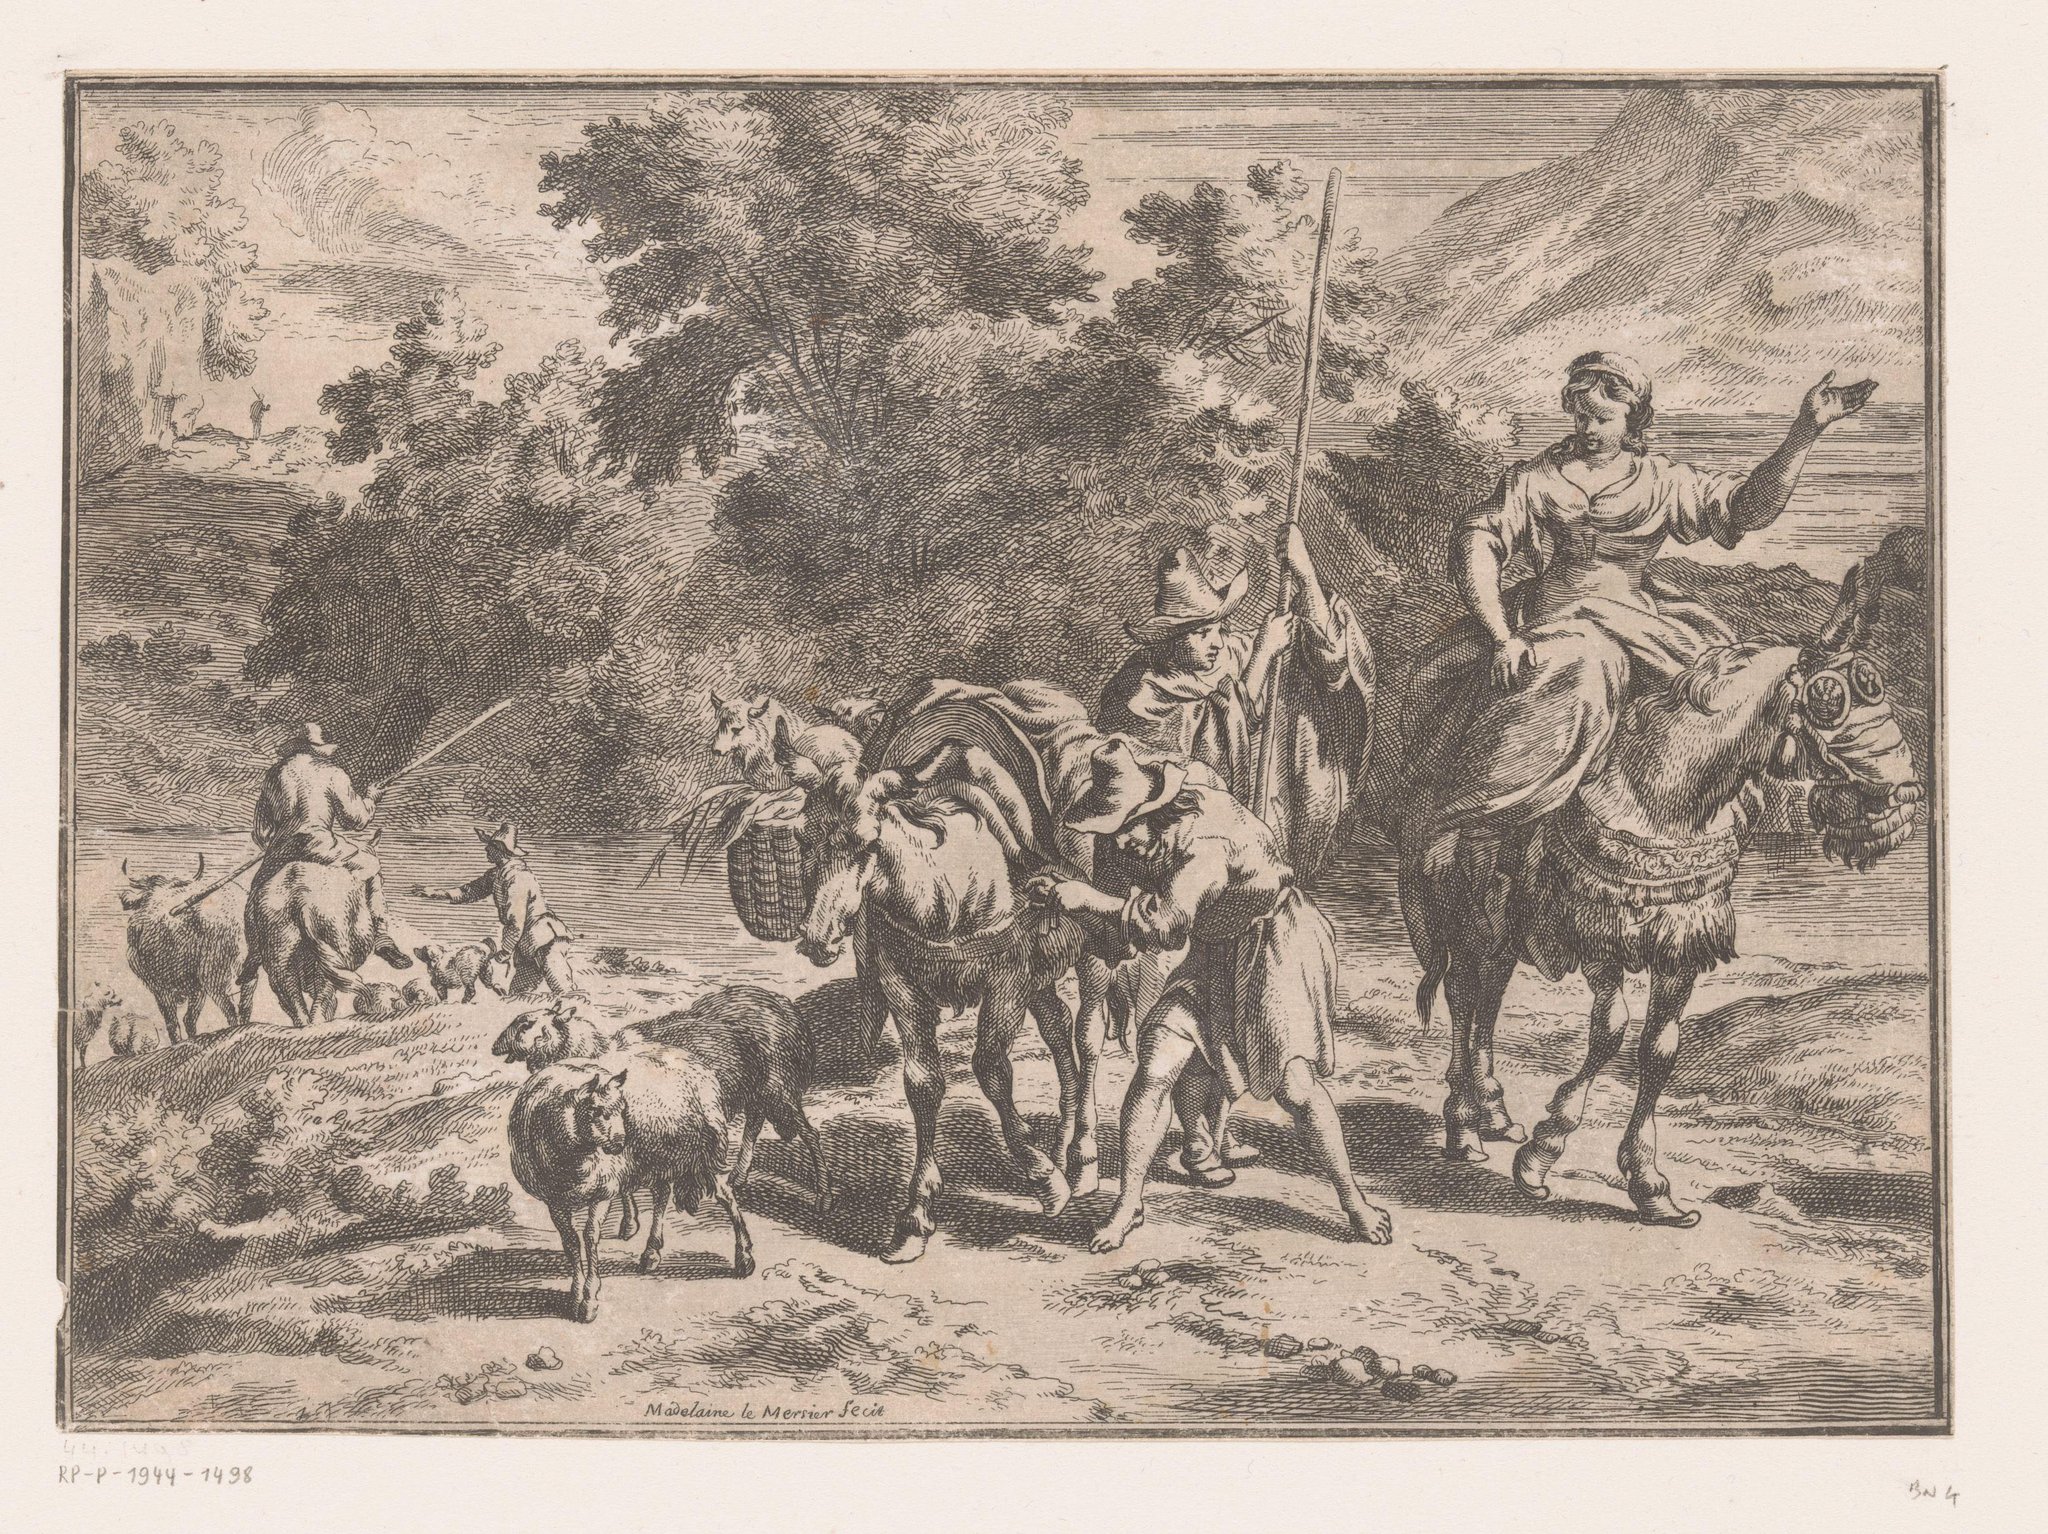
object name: print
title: Schapenherders met ezels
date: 1650-1750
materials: paper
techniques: etching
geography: paris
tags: ass, donkey, cattle driving, cattle driver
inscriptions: collector's mark: Lugt 2228